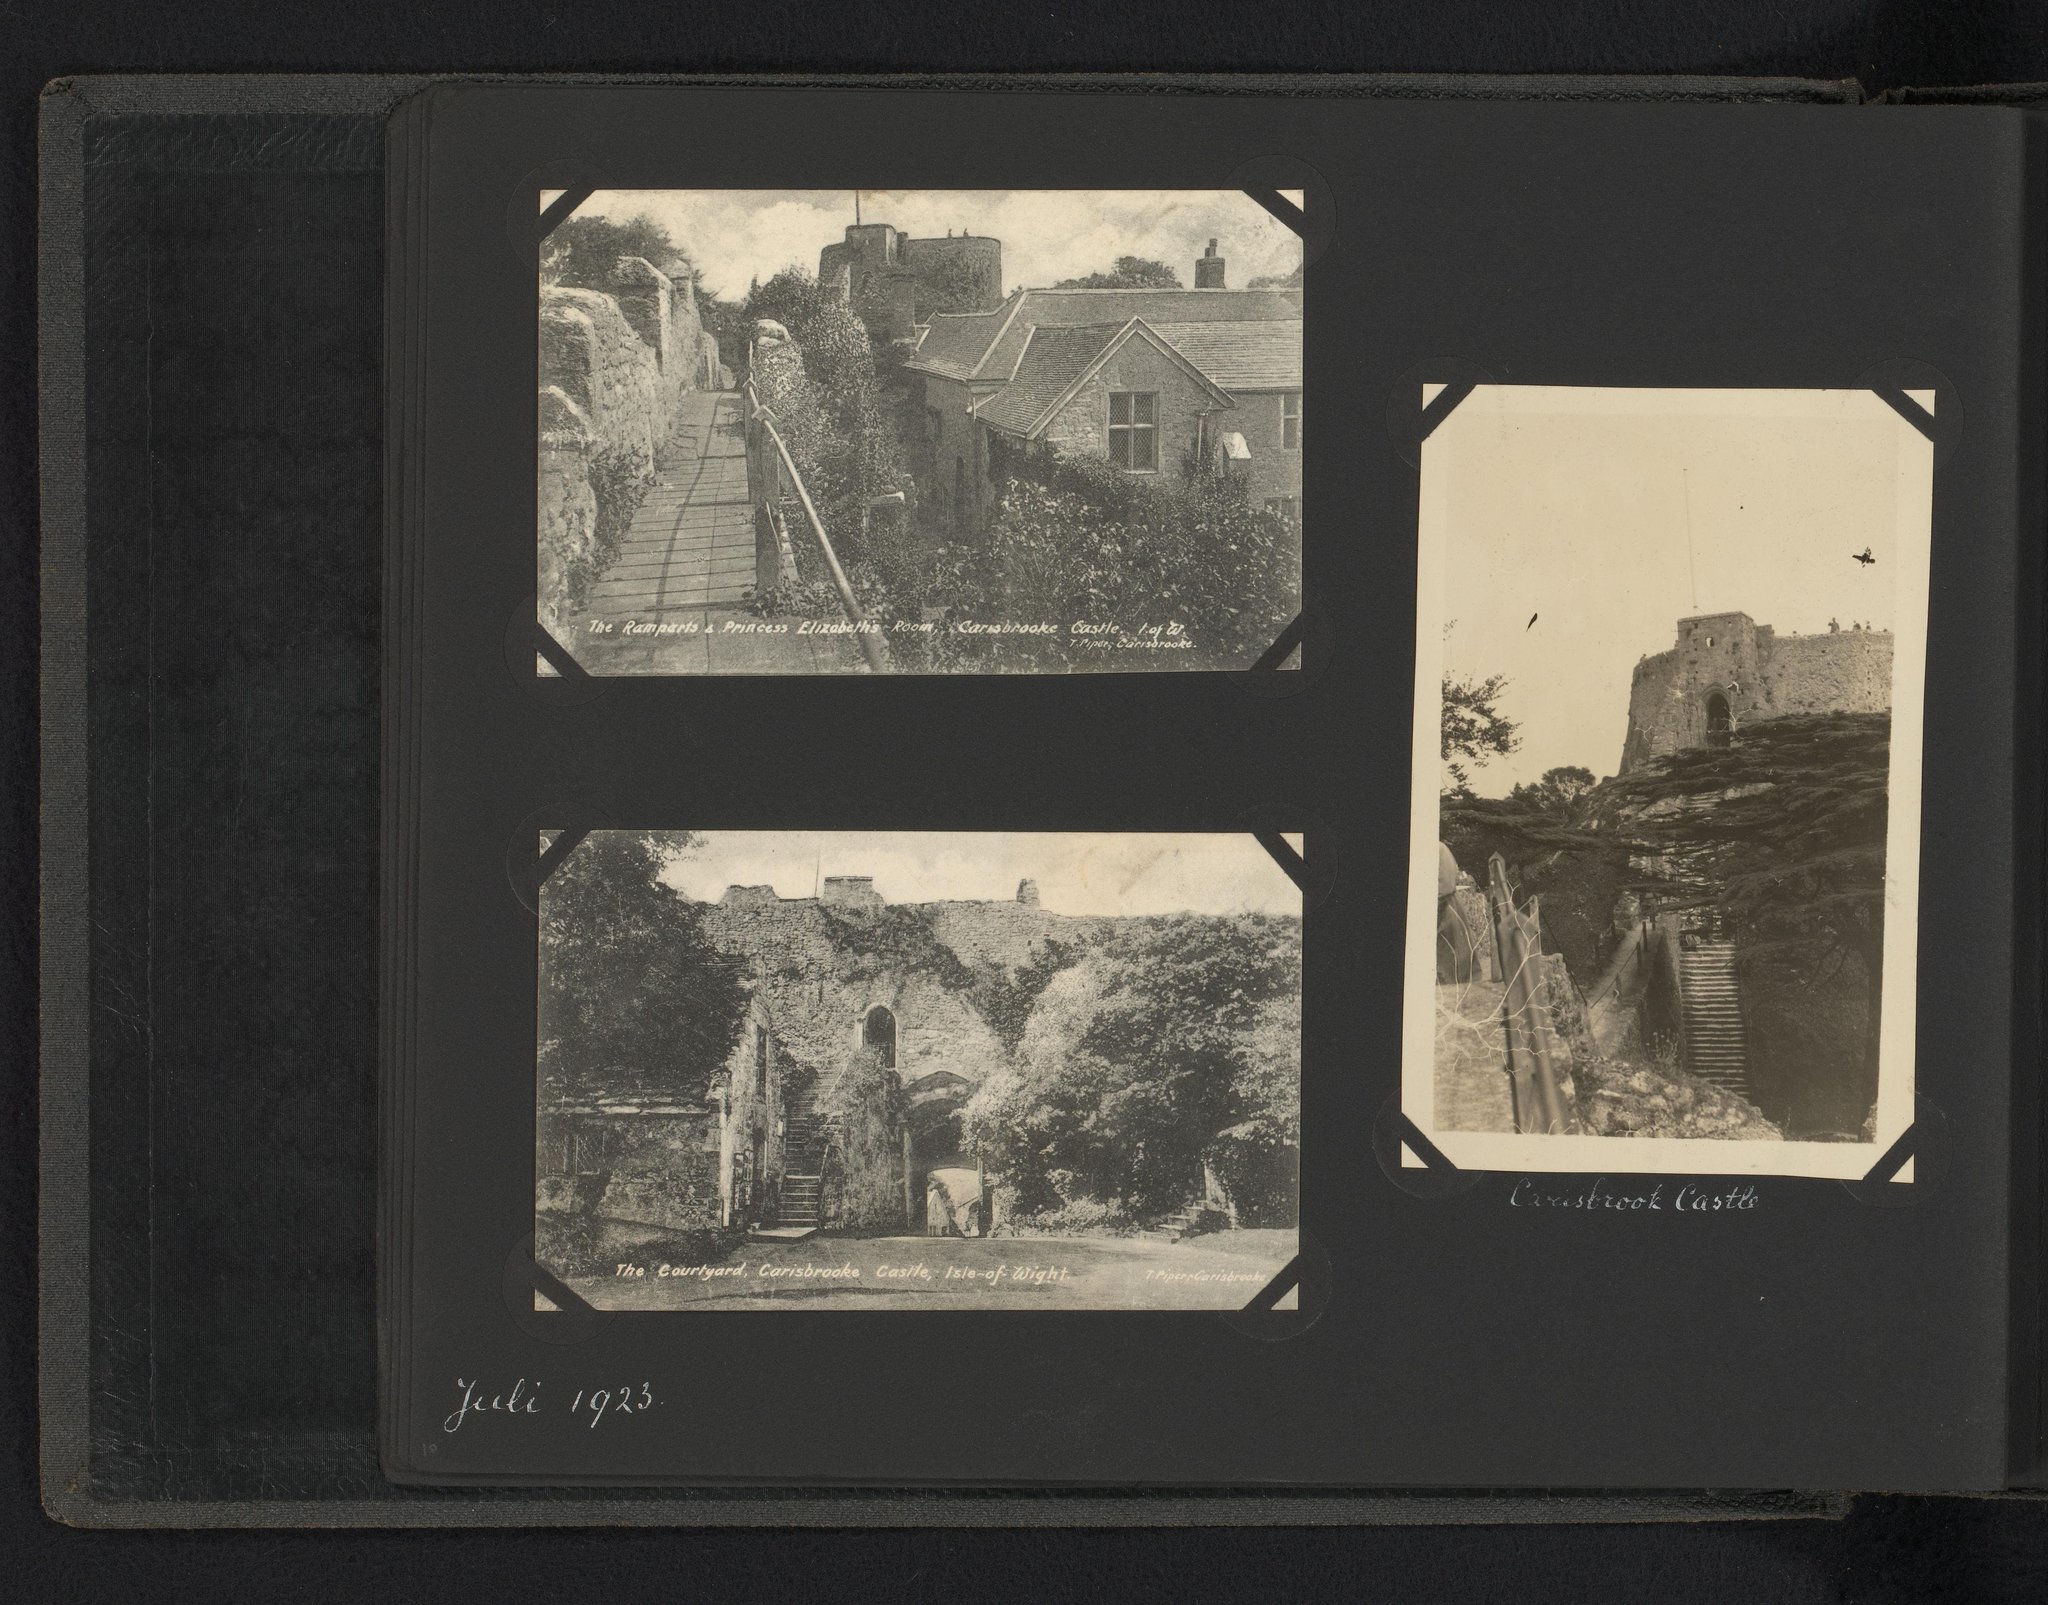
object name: album leaf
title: Juli 1923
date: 1907-1923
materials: paper, cardboard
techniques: photograph, gelatin silver print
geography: isle of wight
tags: castle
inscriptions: inscription: ‘Carisbrook Castle’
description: Deze foto's maken deel uit van een album.